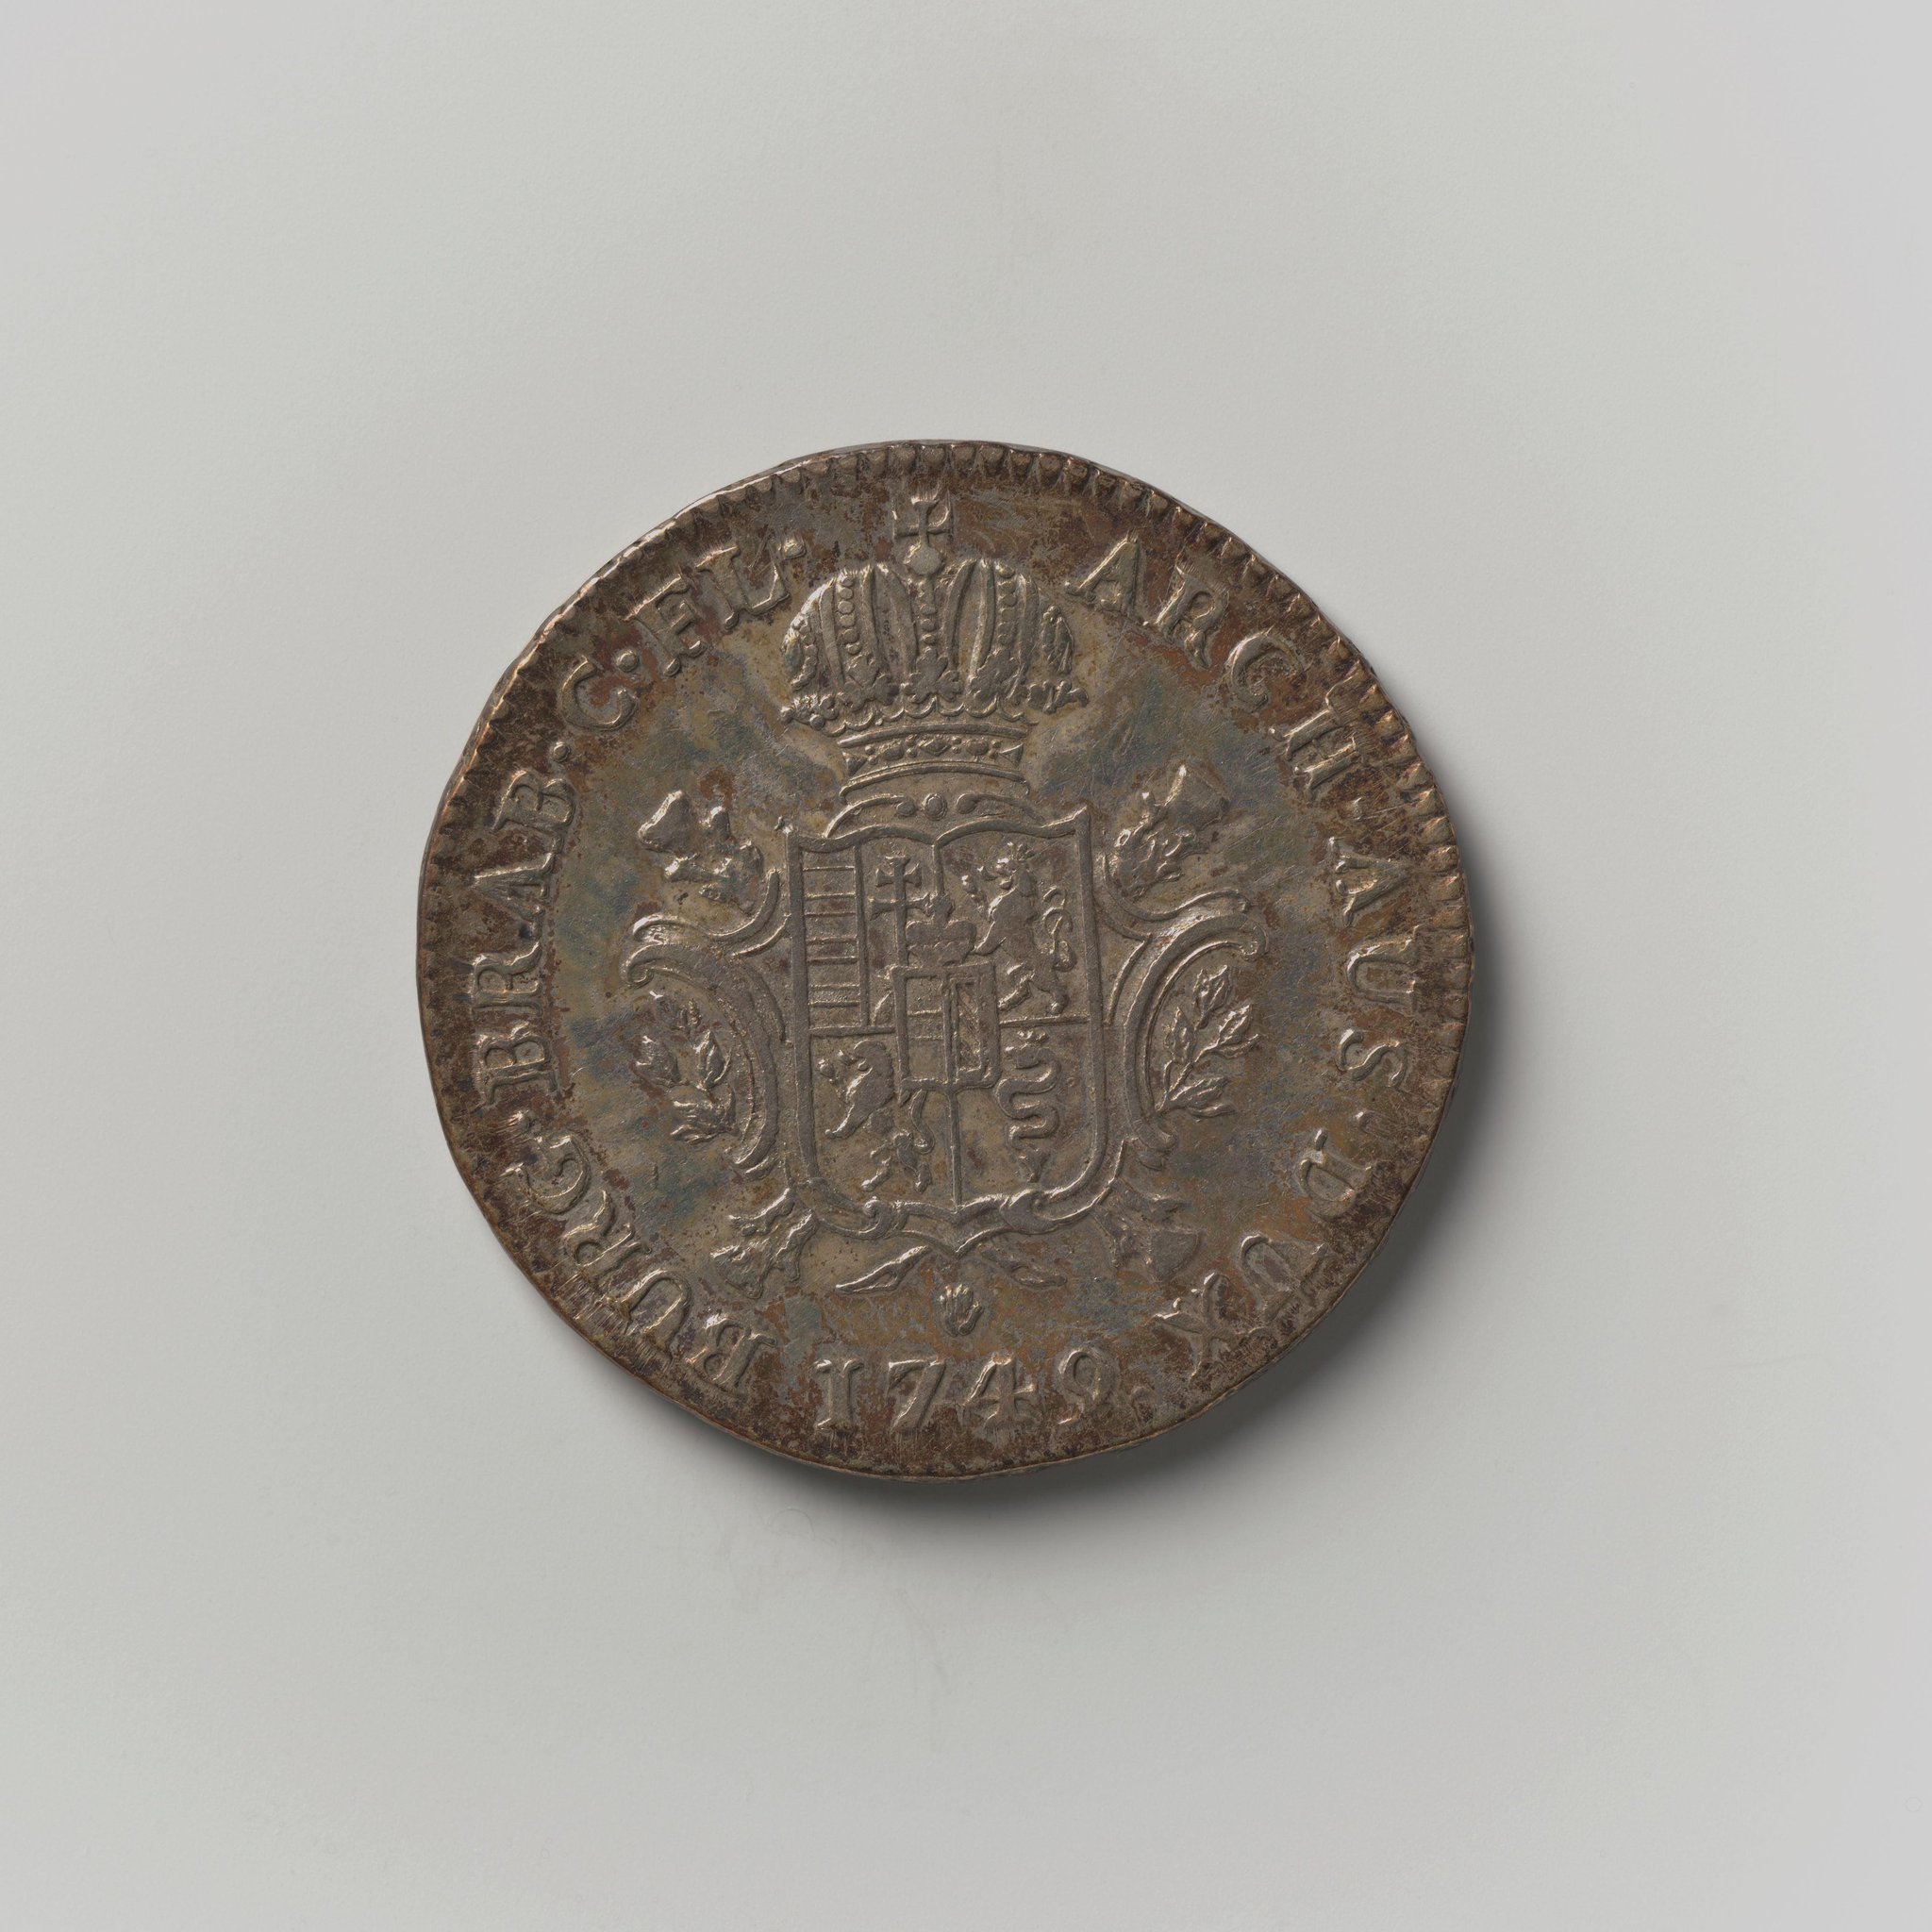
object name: halve dukaton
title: Brabant, Maria-Theresia, halve dukaton, 1749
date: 1749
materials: silver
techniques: striking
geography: antwerp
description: Zilveren munt. Voorzijde: portret van Maria-Theresia naar rechts. Keerzijde: gekroond versierd samengesteld wapenschild, waaronder hand. Jaartal onderaan in omschrift. Opliggend randschrift.